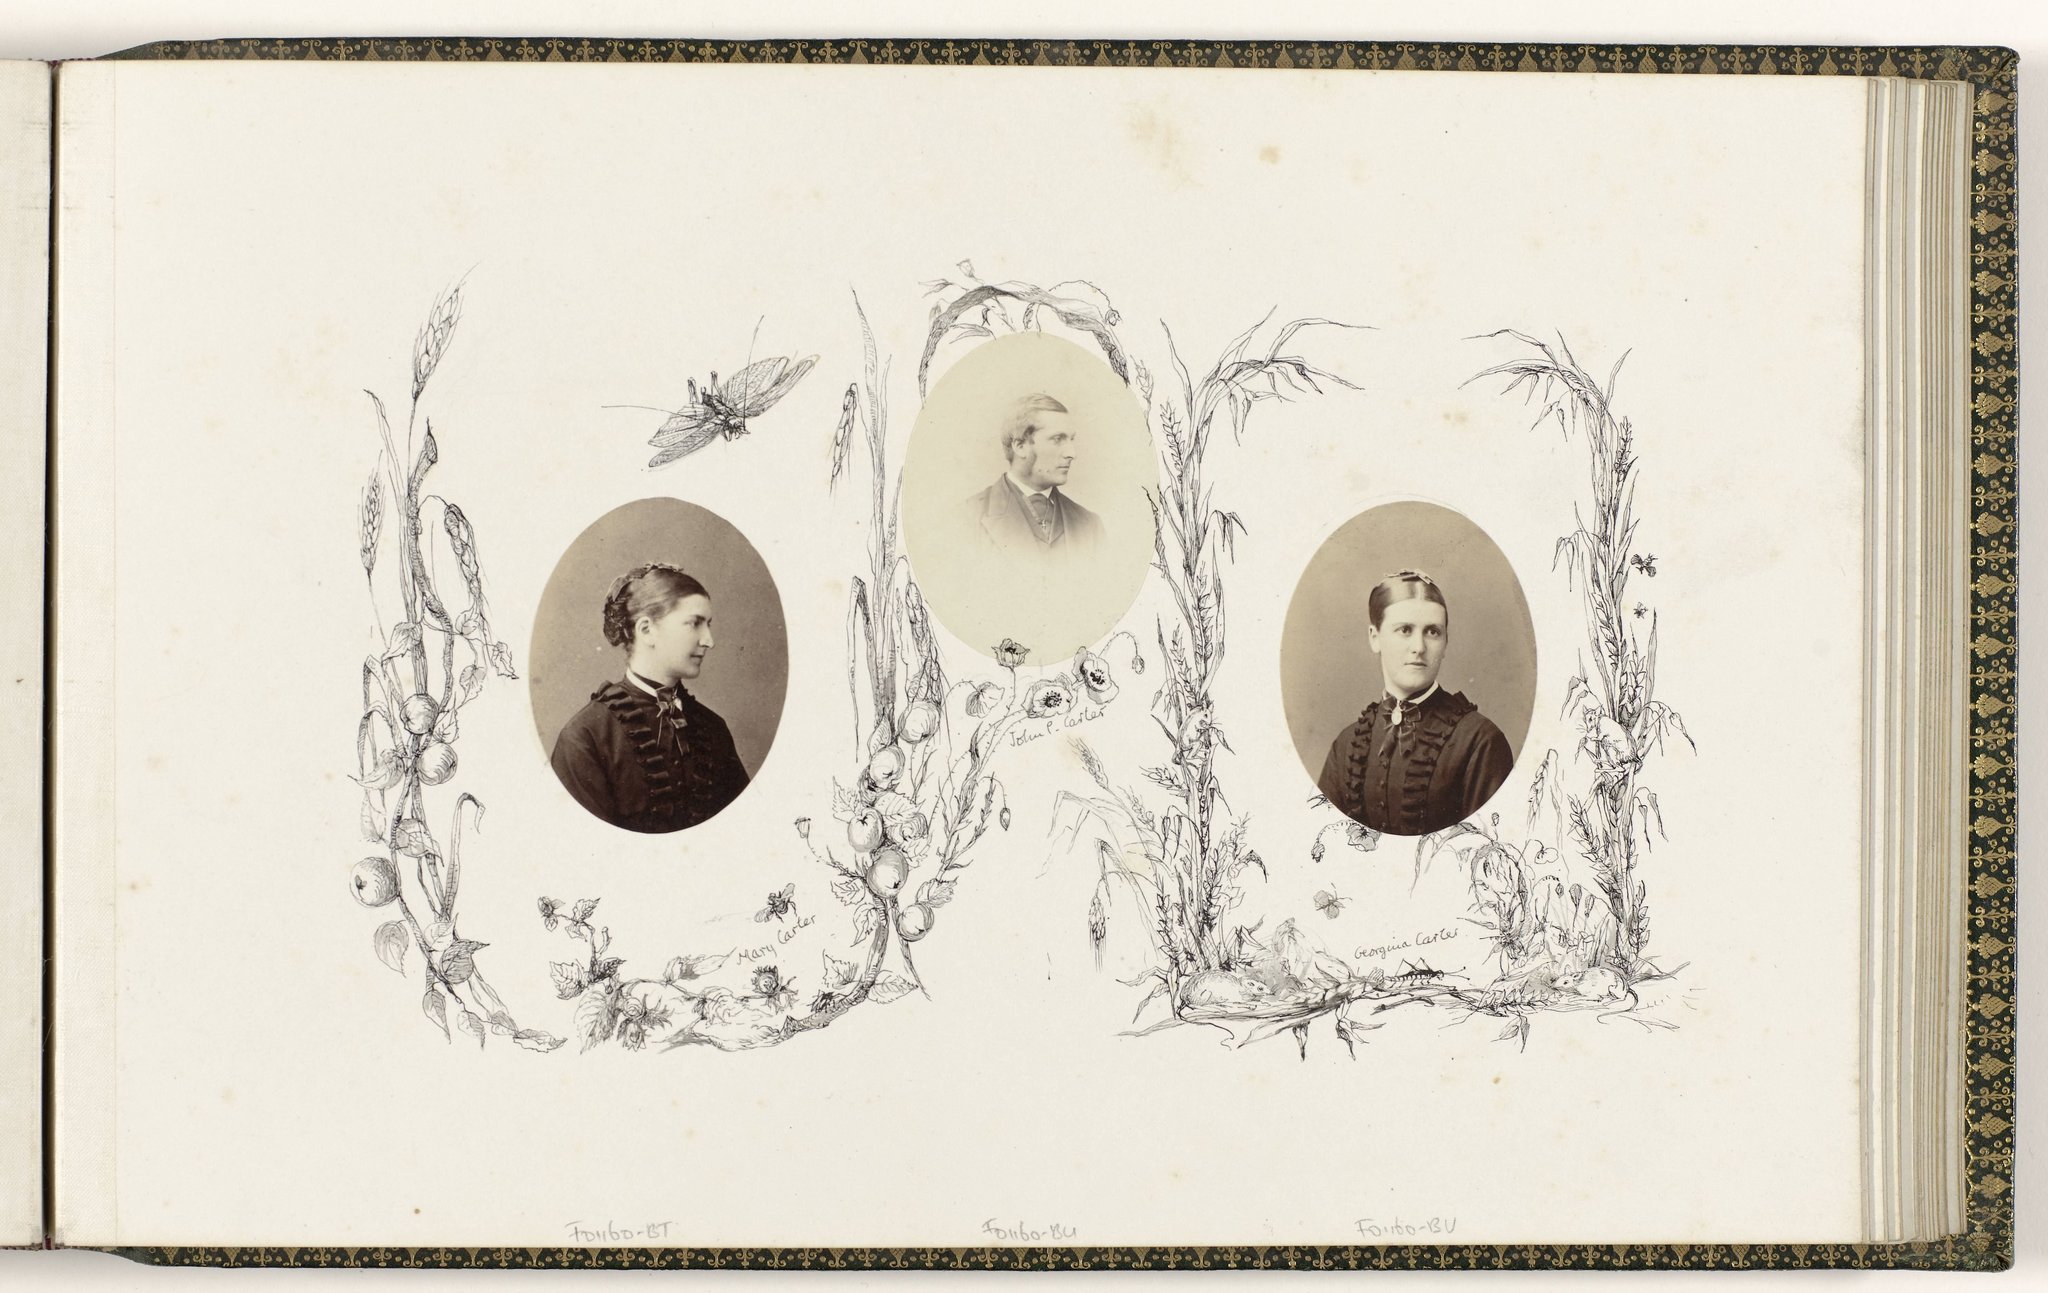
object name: photograph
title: Portret van Mary Carter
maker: Anonymous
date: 1870-1880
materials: paper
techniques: albumen print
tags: historical persons - bb - woman